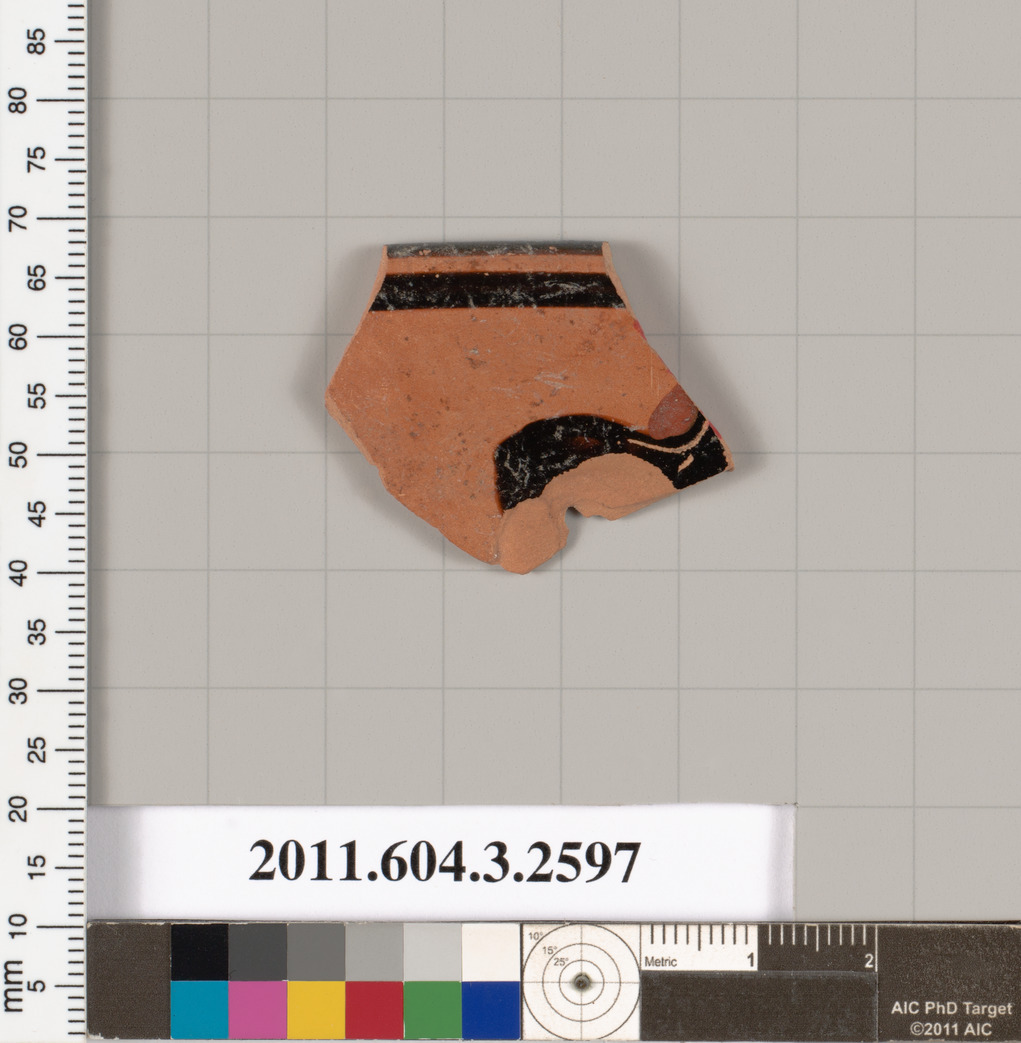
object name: kylix fragment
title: Terracotta rim fragment of a kylix (drinking cup)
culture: greek, attic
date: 550-526 BCE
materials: terracotta